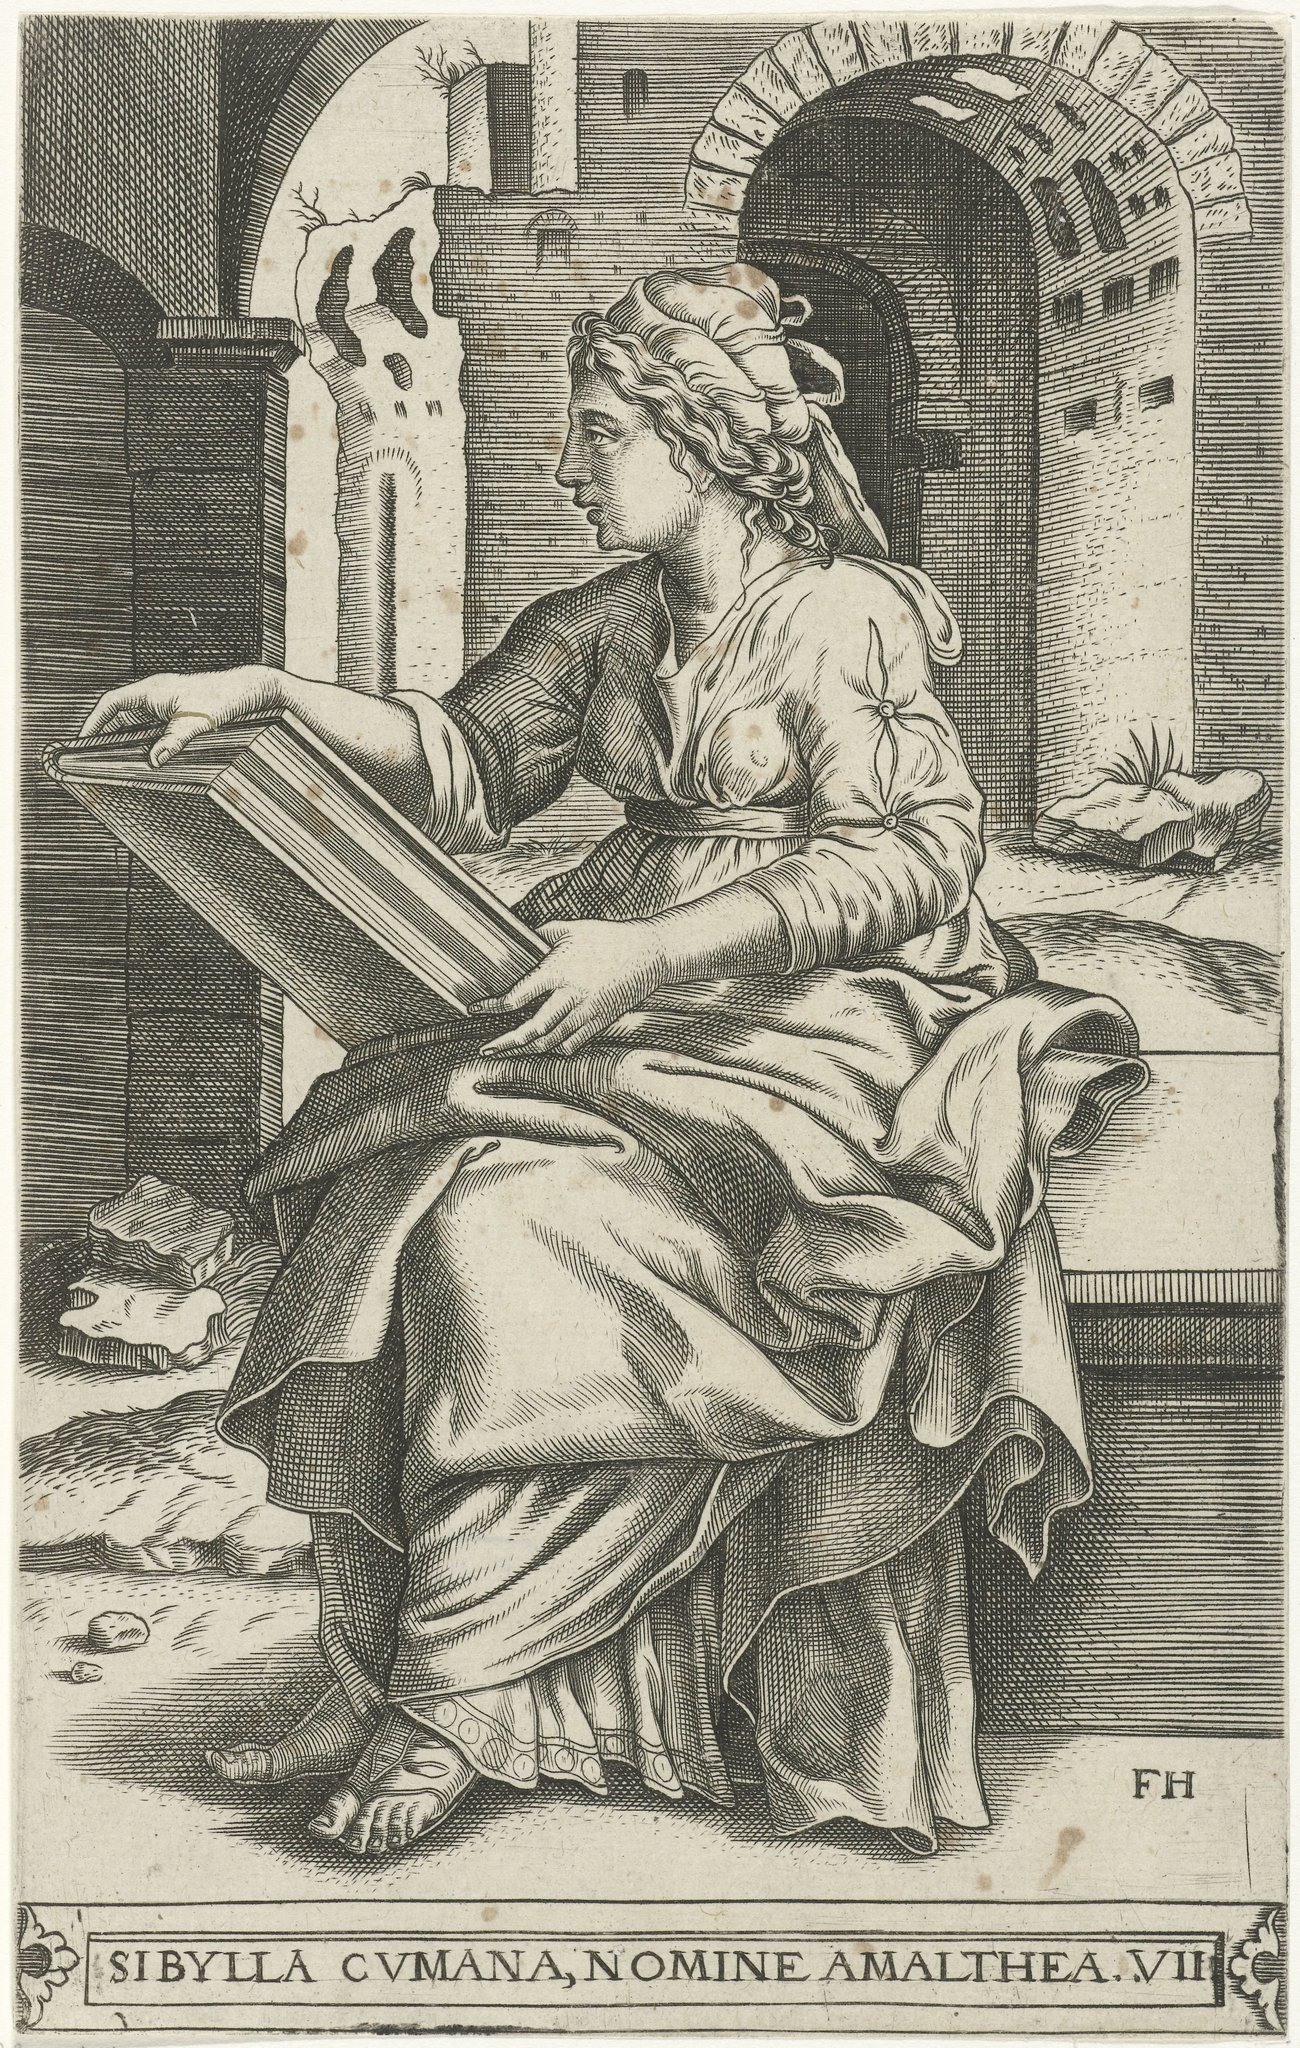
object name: print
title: Sibille van Cumae, genaamd Amalthea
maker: frans huys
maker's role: print maker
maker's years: 1522-1562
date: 1546-1562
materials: paper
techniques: engraving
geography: antwerp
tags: cumaean sibyl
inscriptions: collector's mark: Lugt 2228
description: De Sibille van Cumae zittend naar links met een boek in haar handen. Op de achtergrond een ruïne. De prent maakt deel uit van een tiendelige serie over de Sibillen.